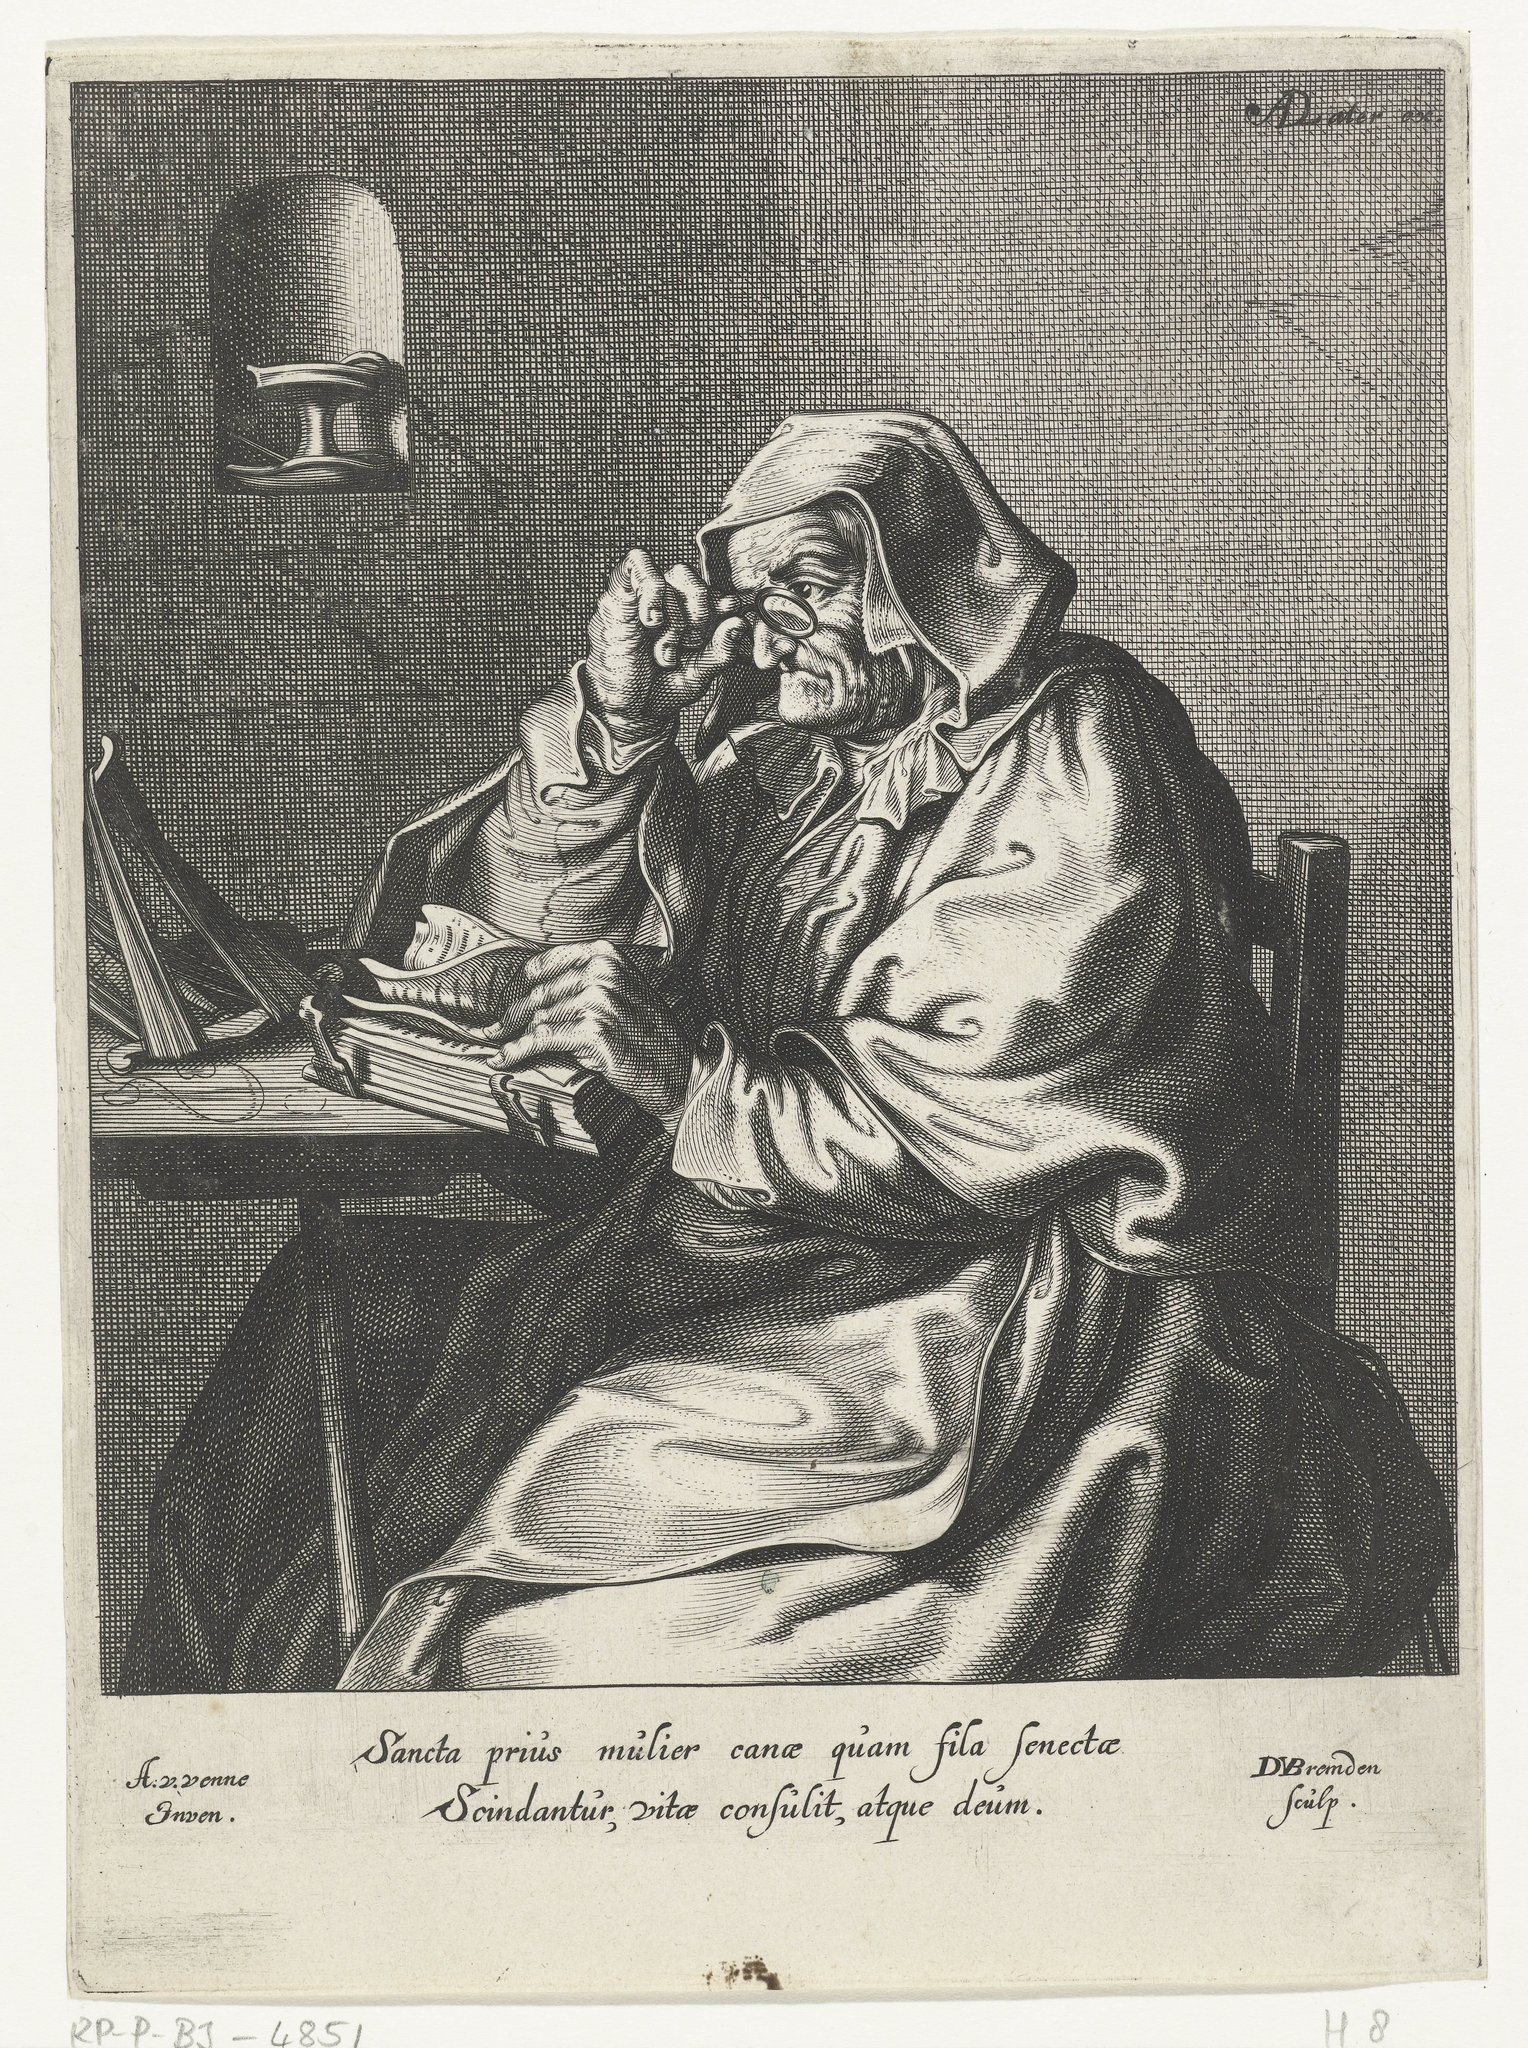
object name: print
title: Lezende oude vrouw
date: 1625-1665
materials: paper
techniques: engraving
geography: flushing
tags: eyeglasses, spectacles, reading, old woman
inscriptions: collector's mark: Lugt 240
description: Een oude vrouw zit aan tafel en leest in een boek. Voor haar ogen houdt ze een bril. In een nis in de muur staat een olielamp. Onder de voorstelling een Latijns vers.